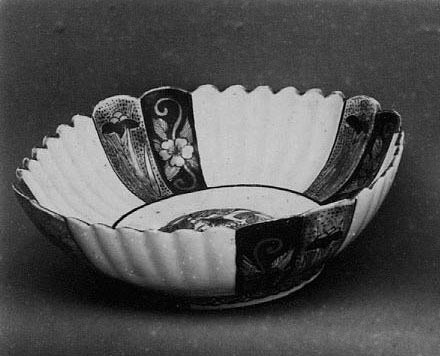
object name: dish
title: Vegetable Dish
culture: japanese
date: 1800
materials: enamel, porcelain